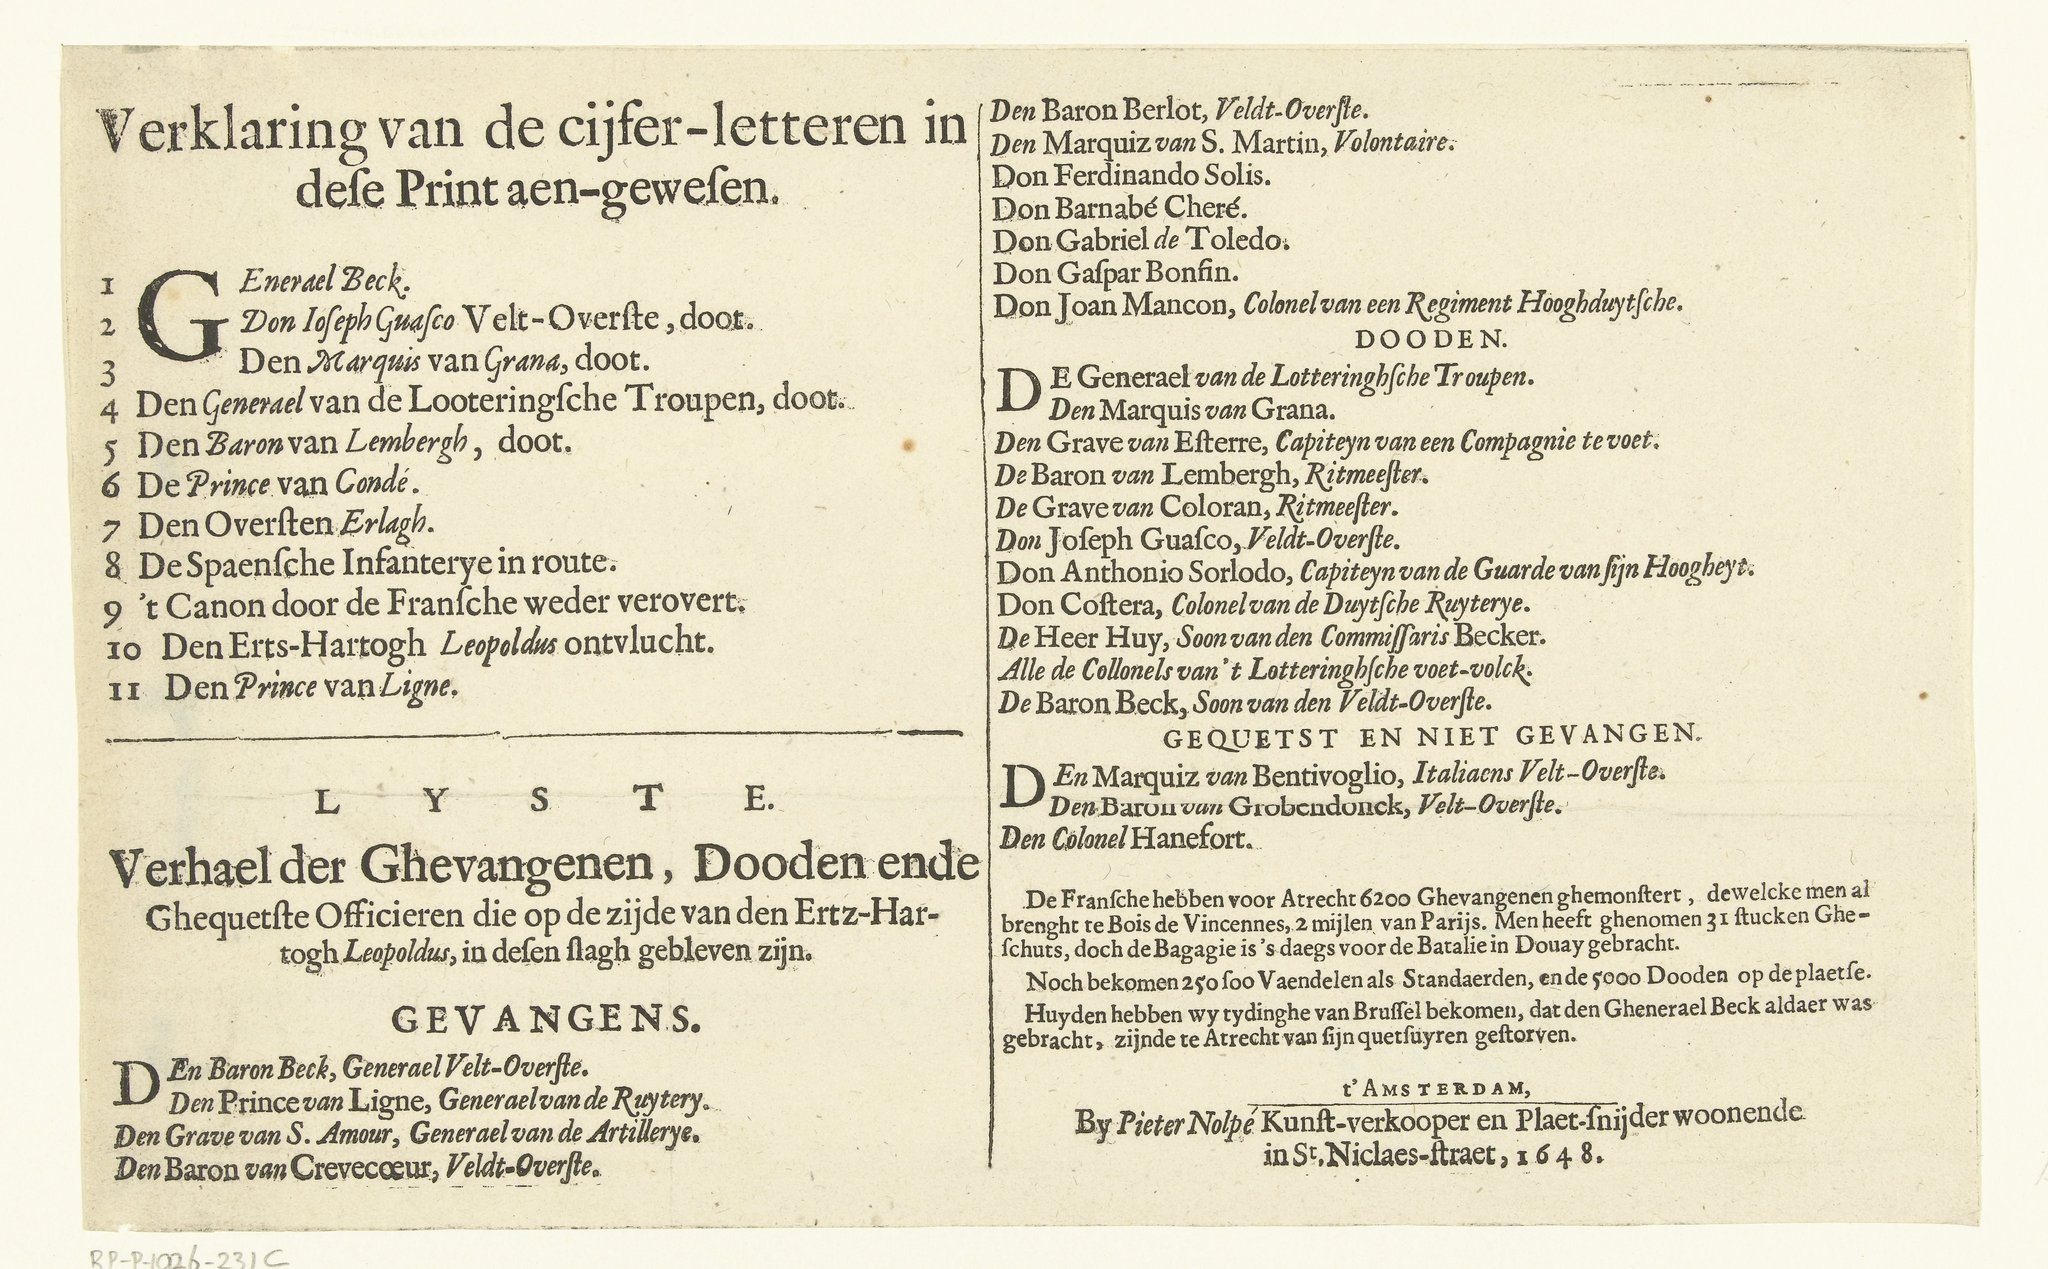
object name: print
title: Legenda bij de prent van het gevecht bij Lens, 1648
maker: pieter nolpe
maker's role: draughtsman, print maker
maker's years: 1613-1653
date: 1648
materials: paper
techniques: letterpress printing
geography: amsterdam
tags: vienna, leopold willem van oostenrijk (landvoogd der zuidelijke nederlanden), paris, lodewijk ii de bourbon-condé (hertog van enghien)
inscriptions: collector's mark: Lugt 2228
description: In de collectie Frederik Muller opgezet bij de prent van Pieter Nolpe van de slag bij Aschaffenburg (4 augustus 1674), FM 2574, ten onrechte beschouwd als FM 1965. De prent FM 1965 is niet aanwezig in de collectie historieprenten. In doos Hol. 268 zit een versie van deze prent met twee bijbehorende tekstbladen (RP-P-1926-231A-C) die wellicht overeenkomt met de prent in de collectie Bodel Nijenhuis beschreven door Muller onder FMH 1965.